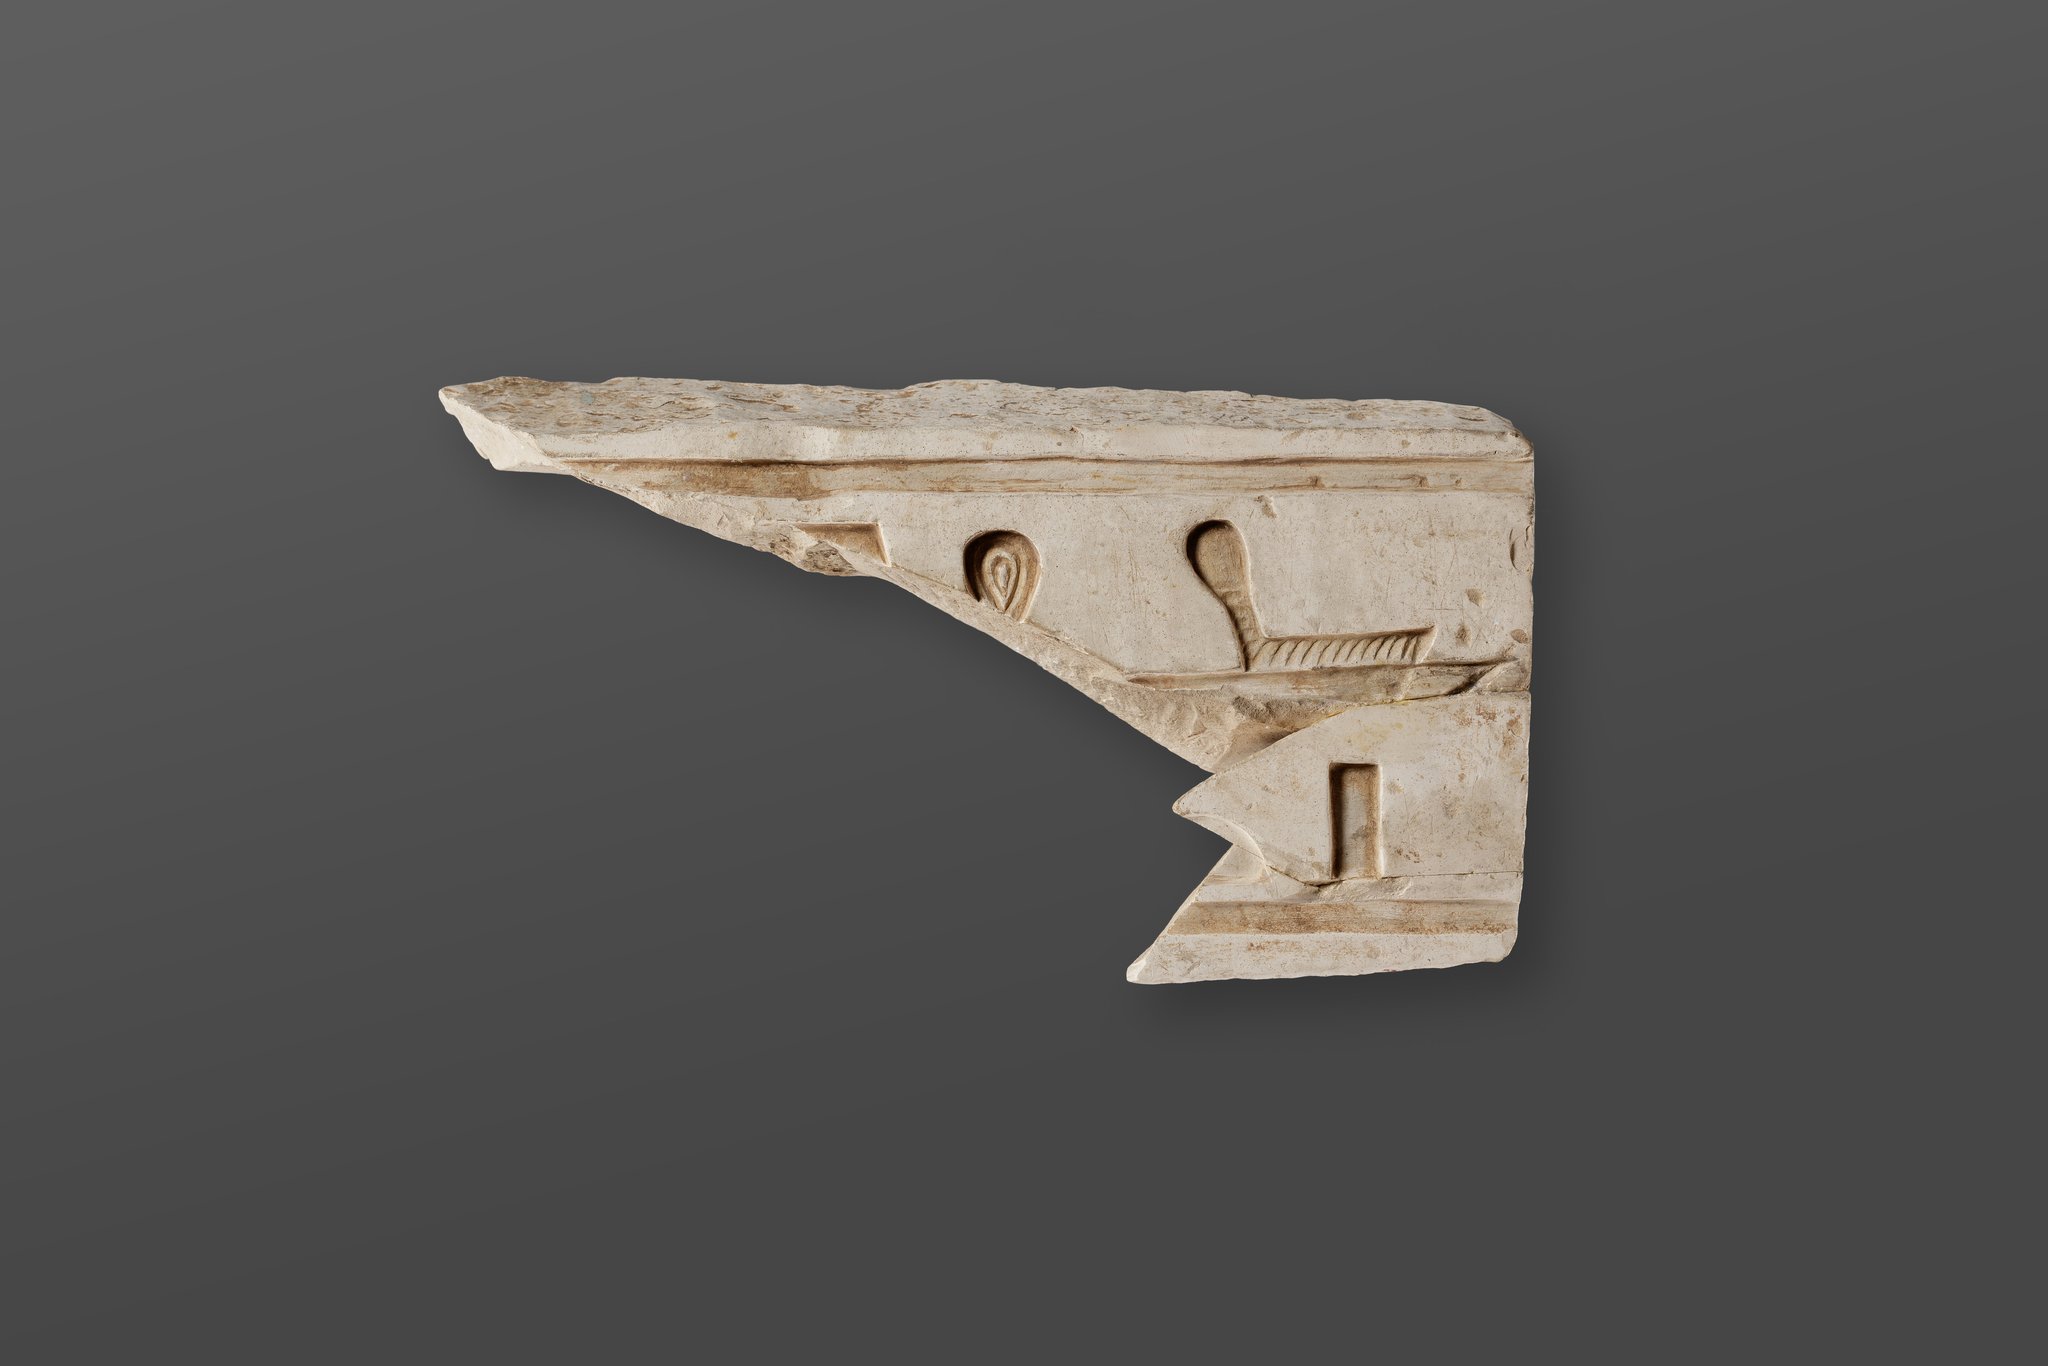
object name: relief fragment, tomb of mereri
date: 2100-2030 BCE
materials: limestone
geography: egypt